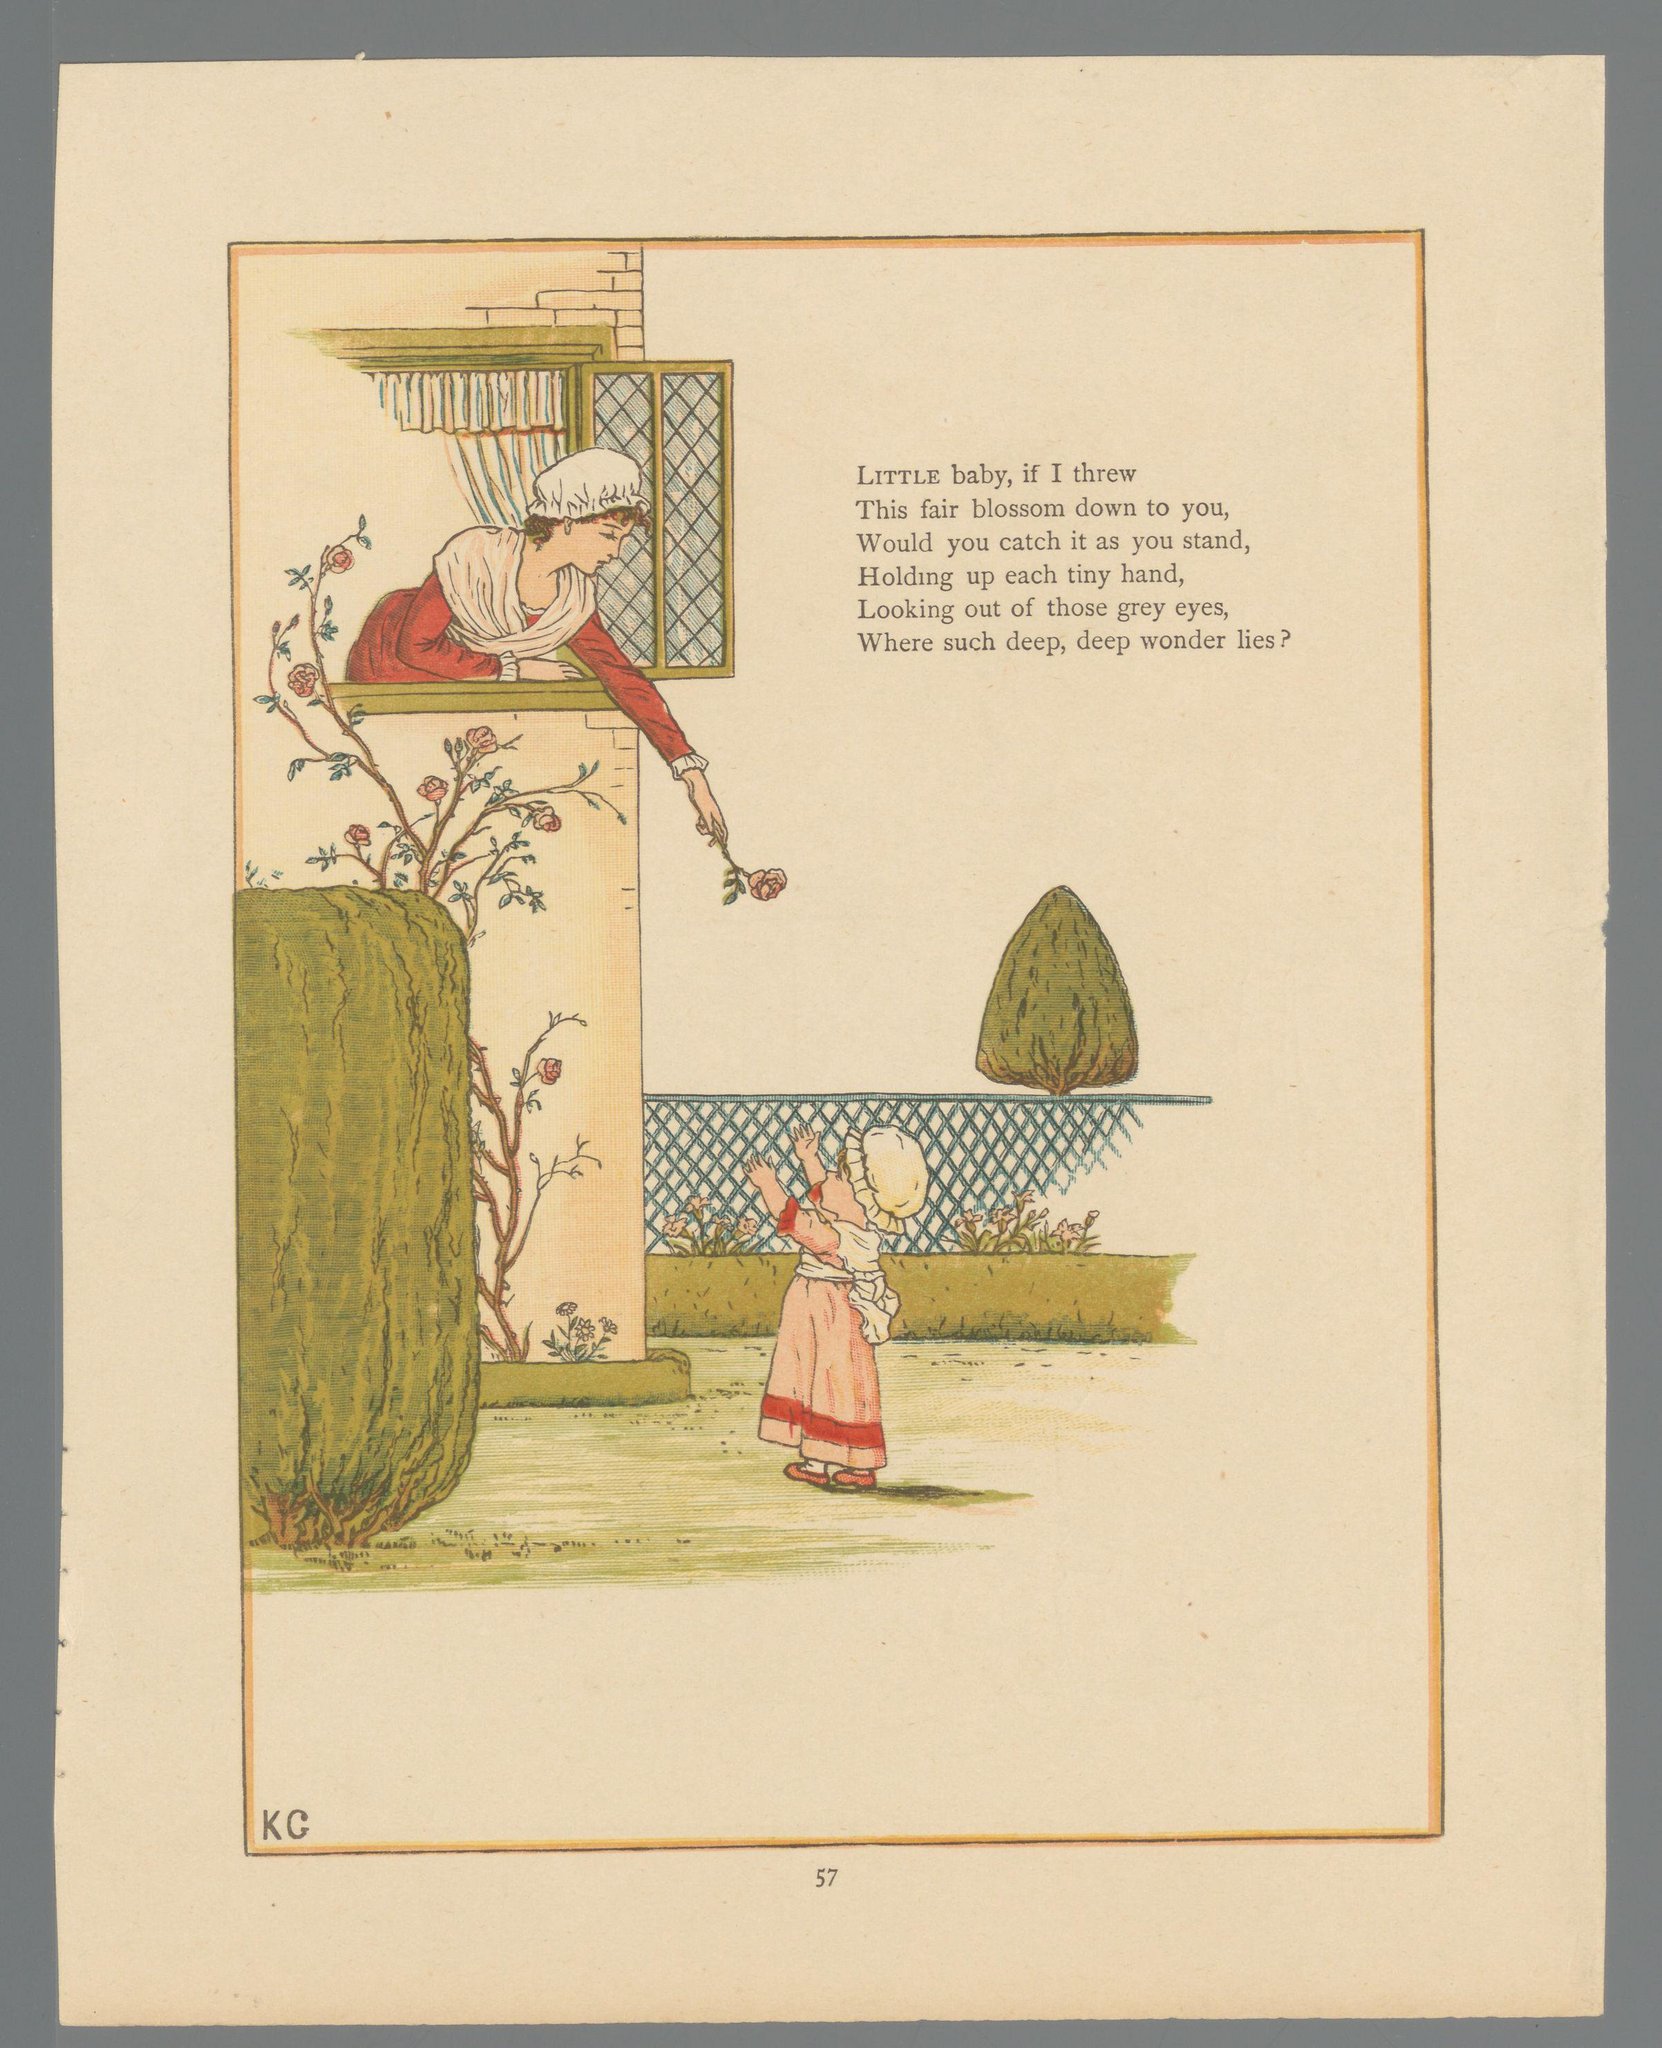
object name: print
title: Vrouw geeft een kind een roos vanuit een raam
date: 1878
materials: paper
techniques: wood engraving, letterpress printing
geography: london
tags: adult woman, child, open window, flowers: rose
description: Prent uit: Greenaway, Kate. Under the window, pictures & rhymes for children. Londen: George Routledge & Sons, 1878, p. 57.